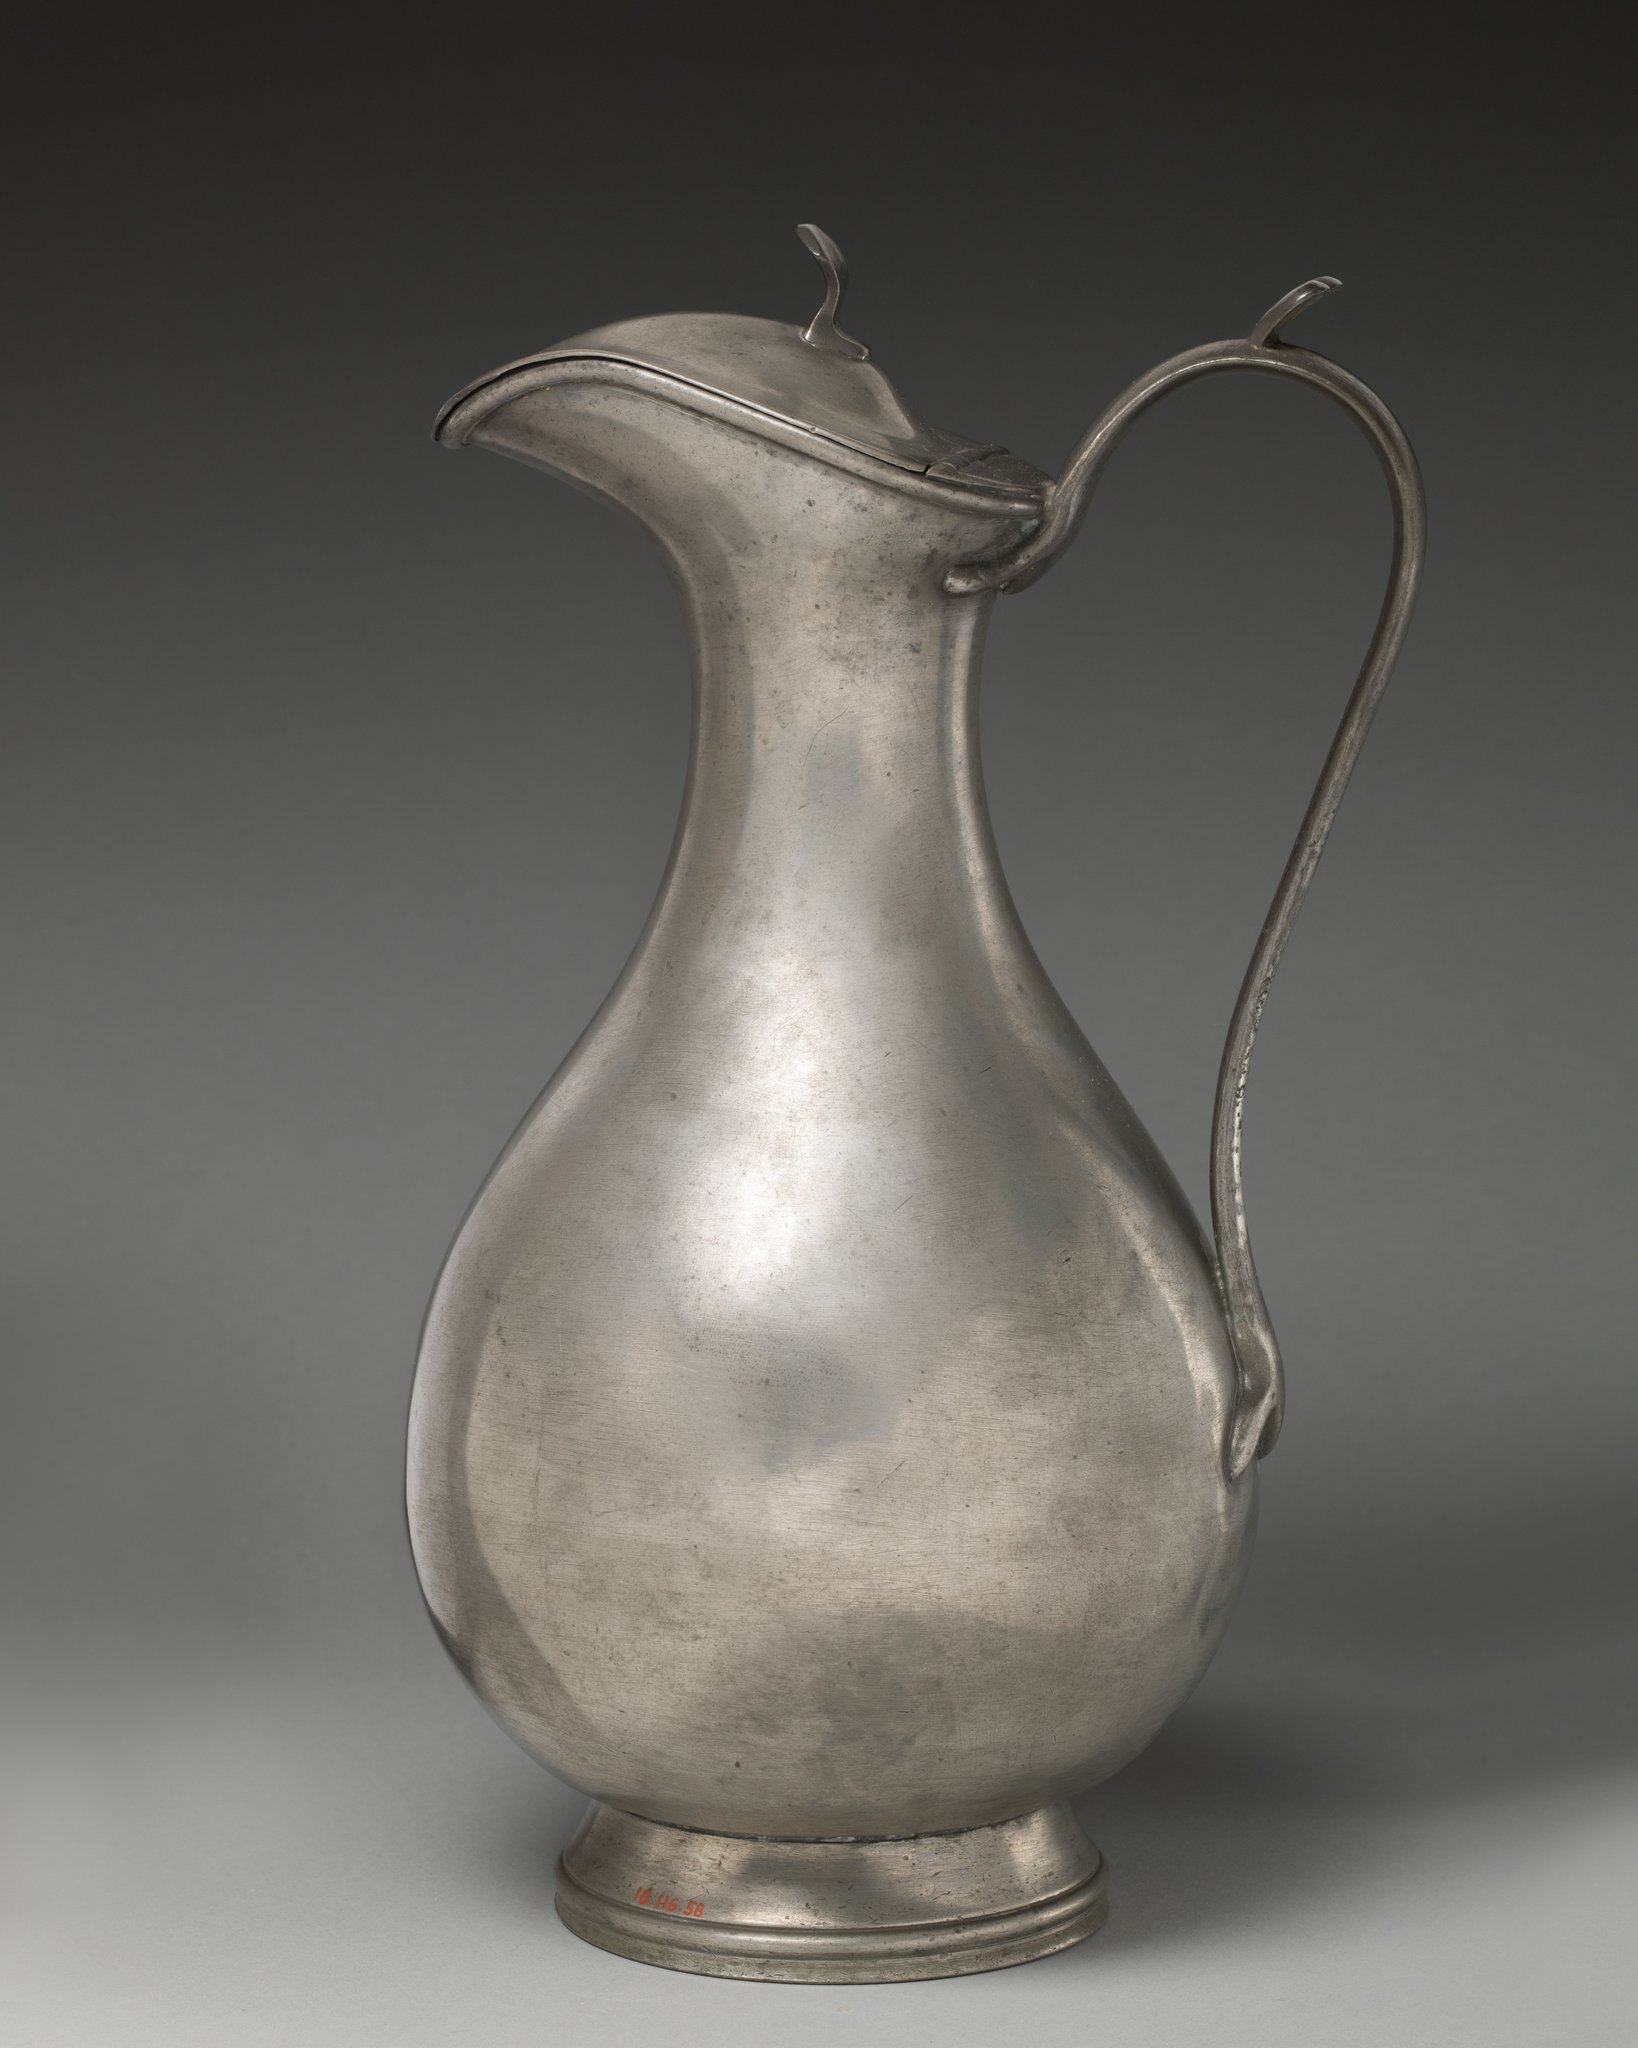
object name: claret jug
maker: james dixon & sons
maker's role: maker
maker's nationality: british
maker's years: 1806-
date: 1870-1879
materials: metal